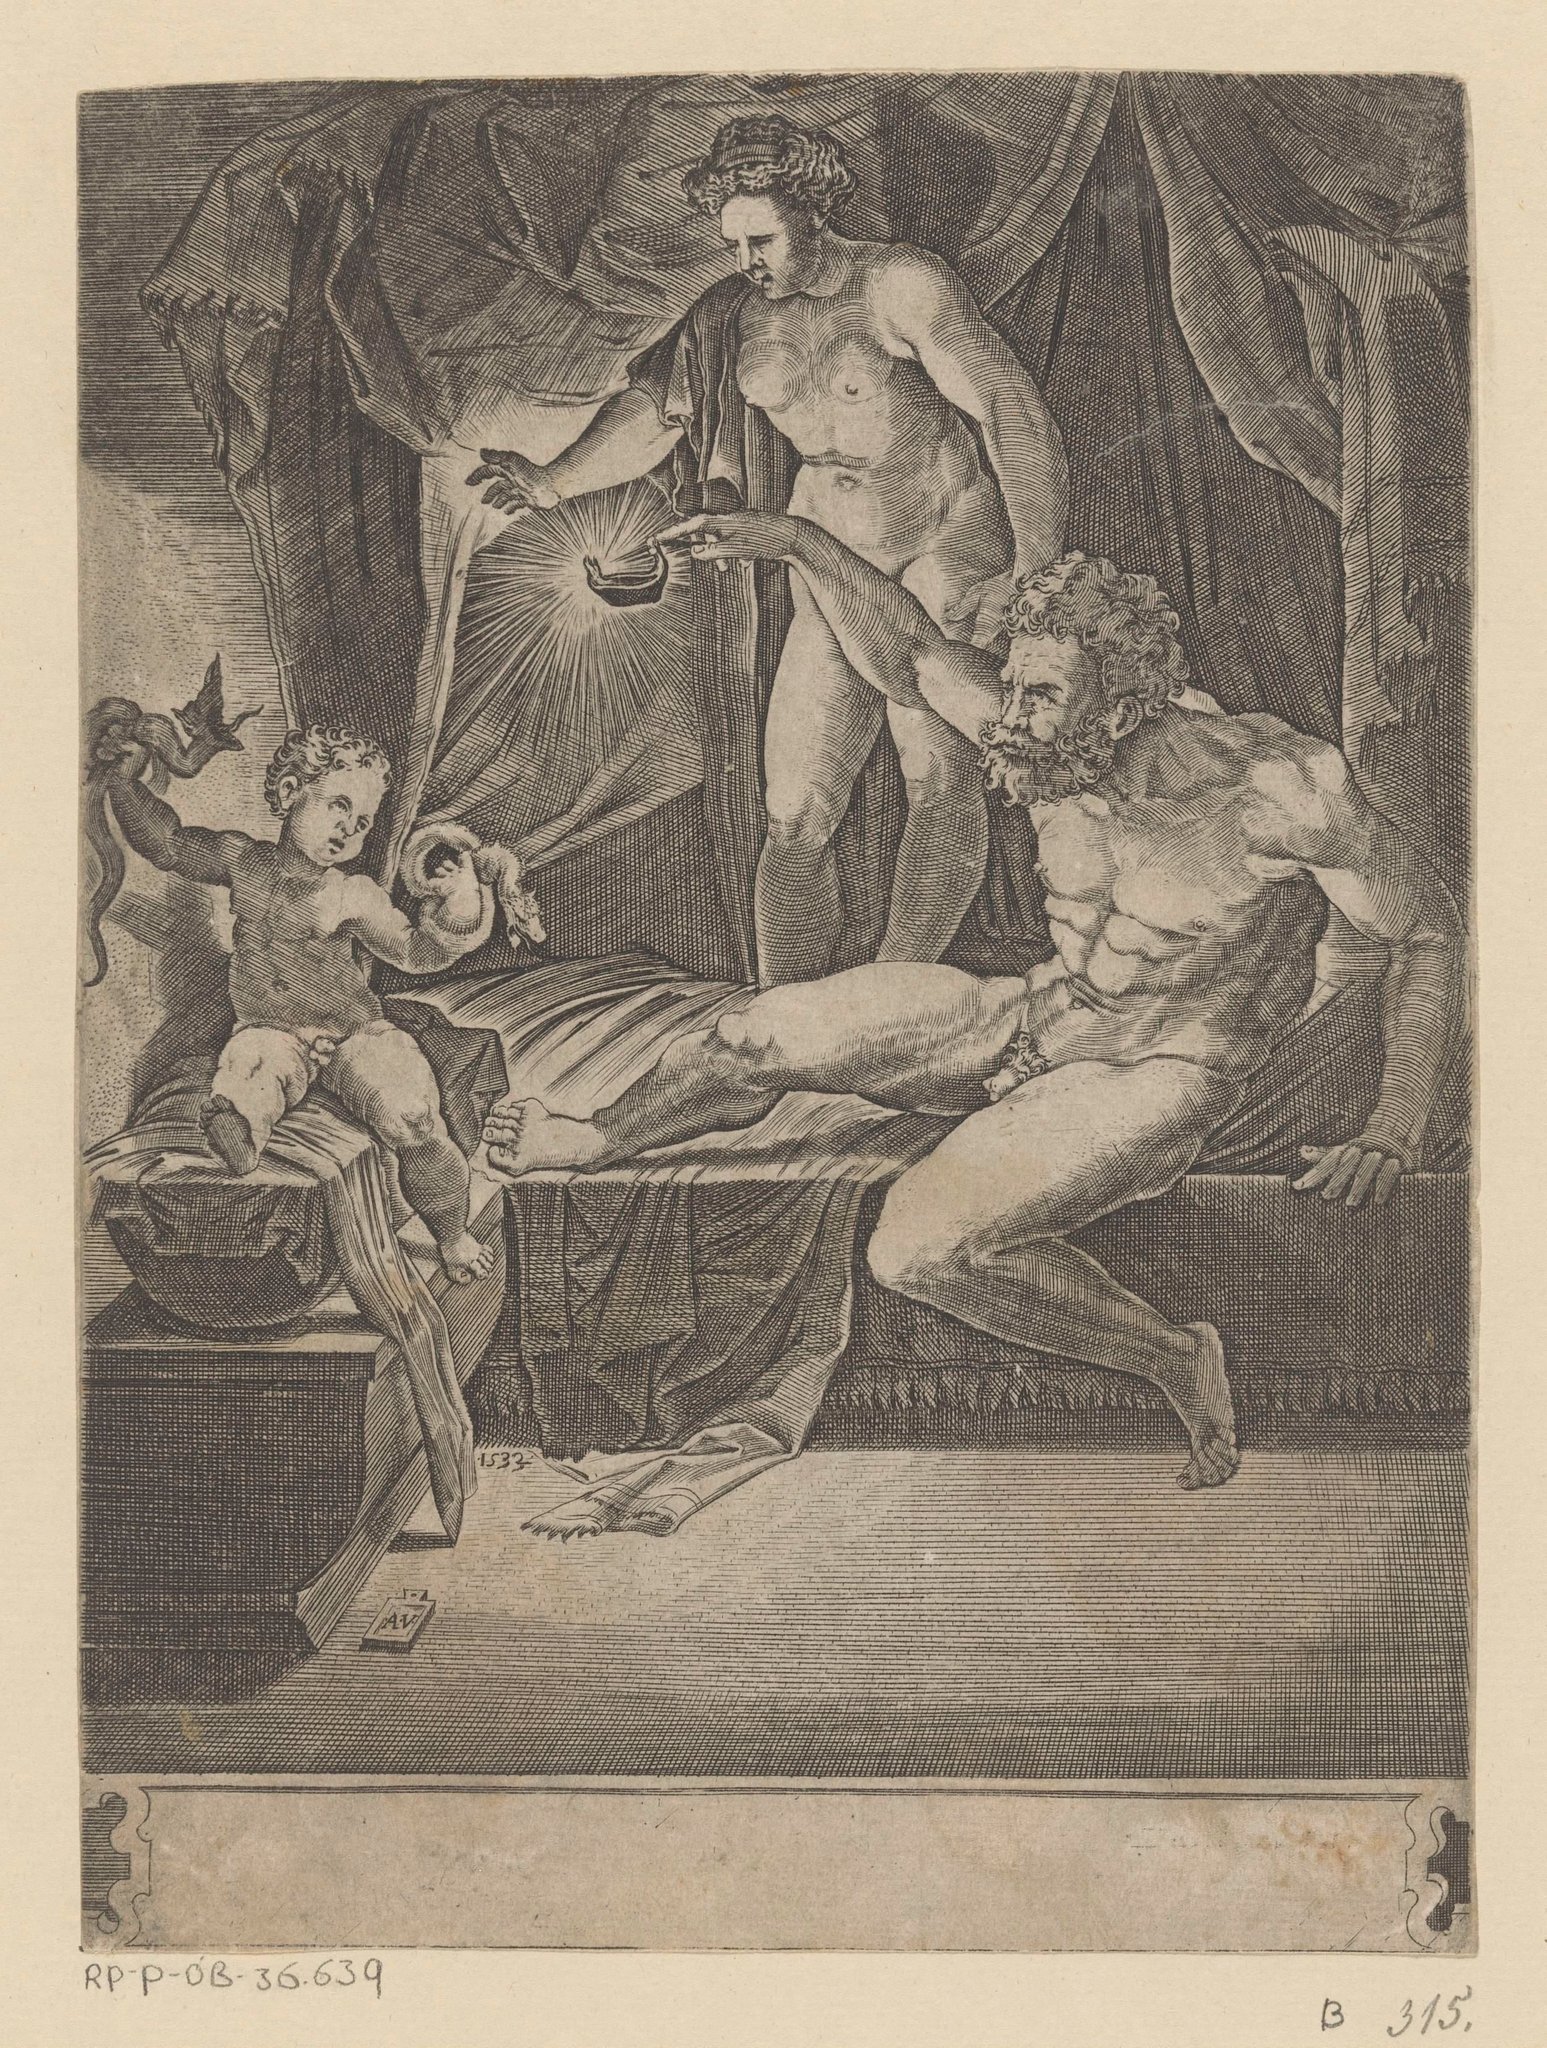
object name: print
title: Hercules doodt de slangen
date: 1533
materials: paper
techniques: engraving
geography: italy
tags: hercules strangles two serpents in his cradle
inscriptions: collector's mark: Lugt 240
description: Van de twee staten in de collectie van het Rijksmuseum, is dit de eerste staat. In RP-P-OB-36.638 (de tweede staat) is de plaat aanzienlijk opgewerkt. Door Bartsch wordt deze prent foutief beschreven als tweede staat. De datering op beide prenten veroorzaakt verwarring. Deze prent is gedateerd 1533, waarbij zichtbaar is dat er voorheen 1532 gestaan geeft, waarna de laatste 2 is veranderd in een 3. RP-P-OB-36.638 is gedateerd 1532, waarbij echter waarschijnlijk de laatste 3 geheel is verwijderd en vervangen door een nieuwe 2.